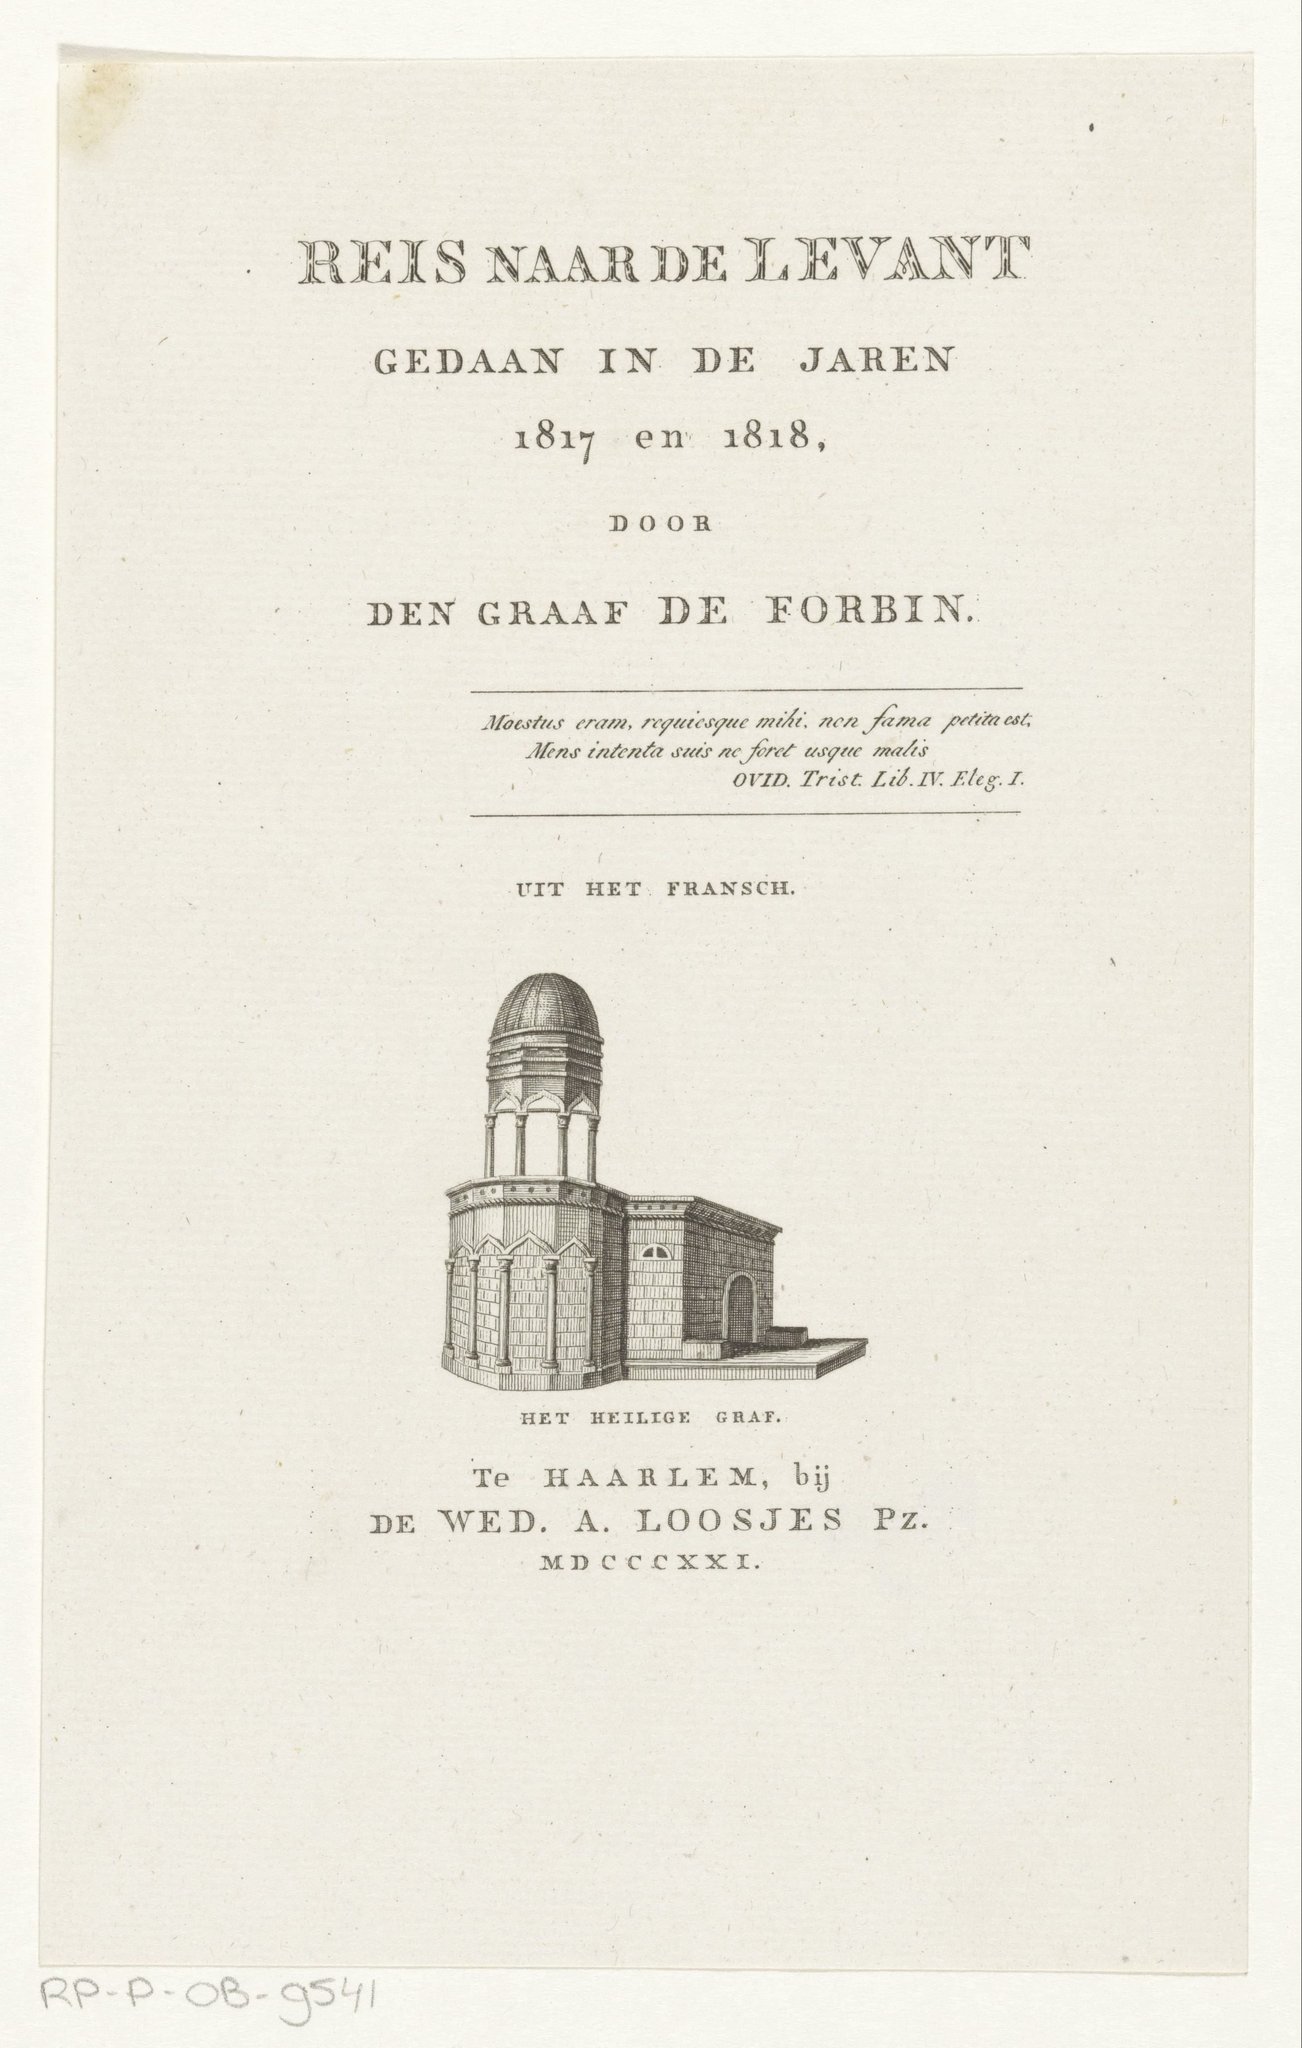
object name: titelblad, titelpagina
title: Heilig Graf in Jeruzalem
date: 1821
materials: paper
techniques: engraving, etching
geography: haarlem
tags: christ, grave, tomb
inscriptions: collector's mark: Lugt 2228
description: Titelpagina voor: Forbin, L.N.P.A. de. Reis naar de Levant gedaan in de jaren 1817 en 1818. Haarlem: Loosjes Pz., weduwe Adriaan, 1821.